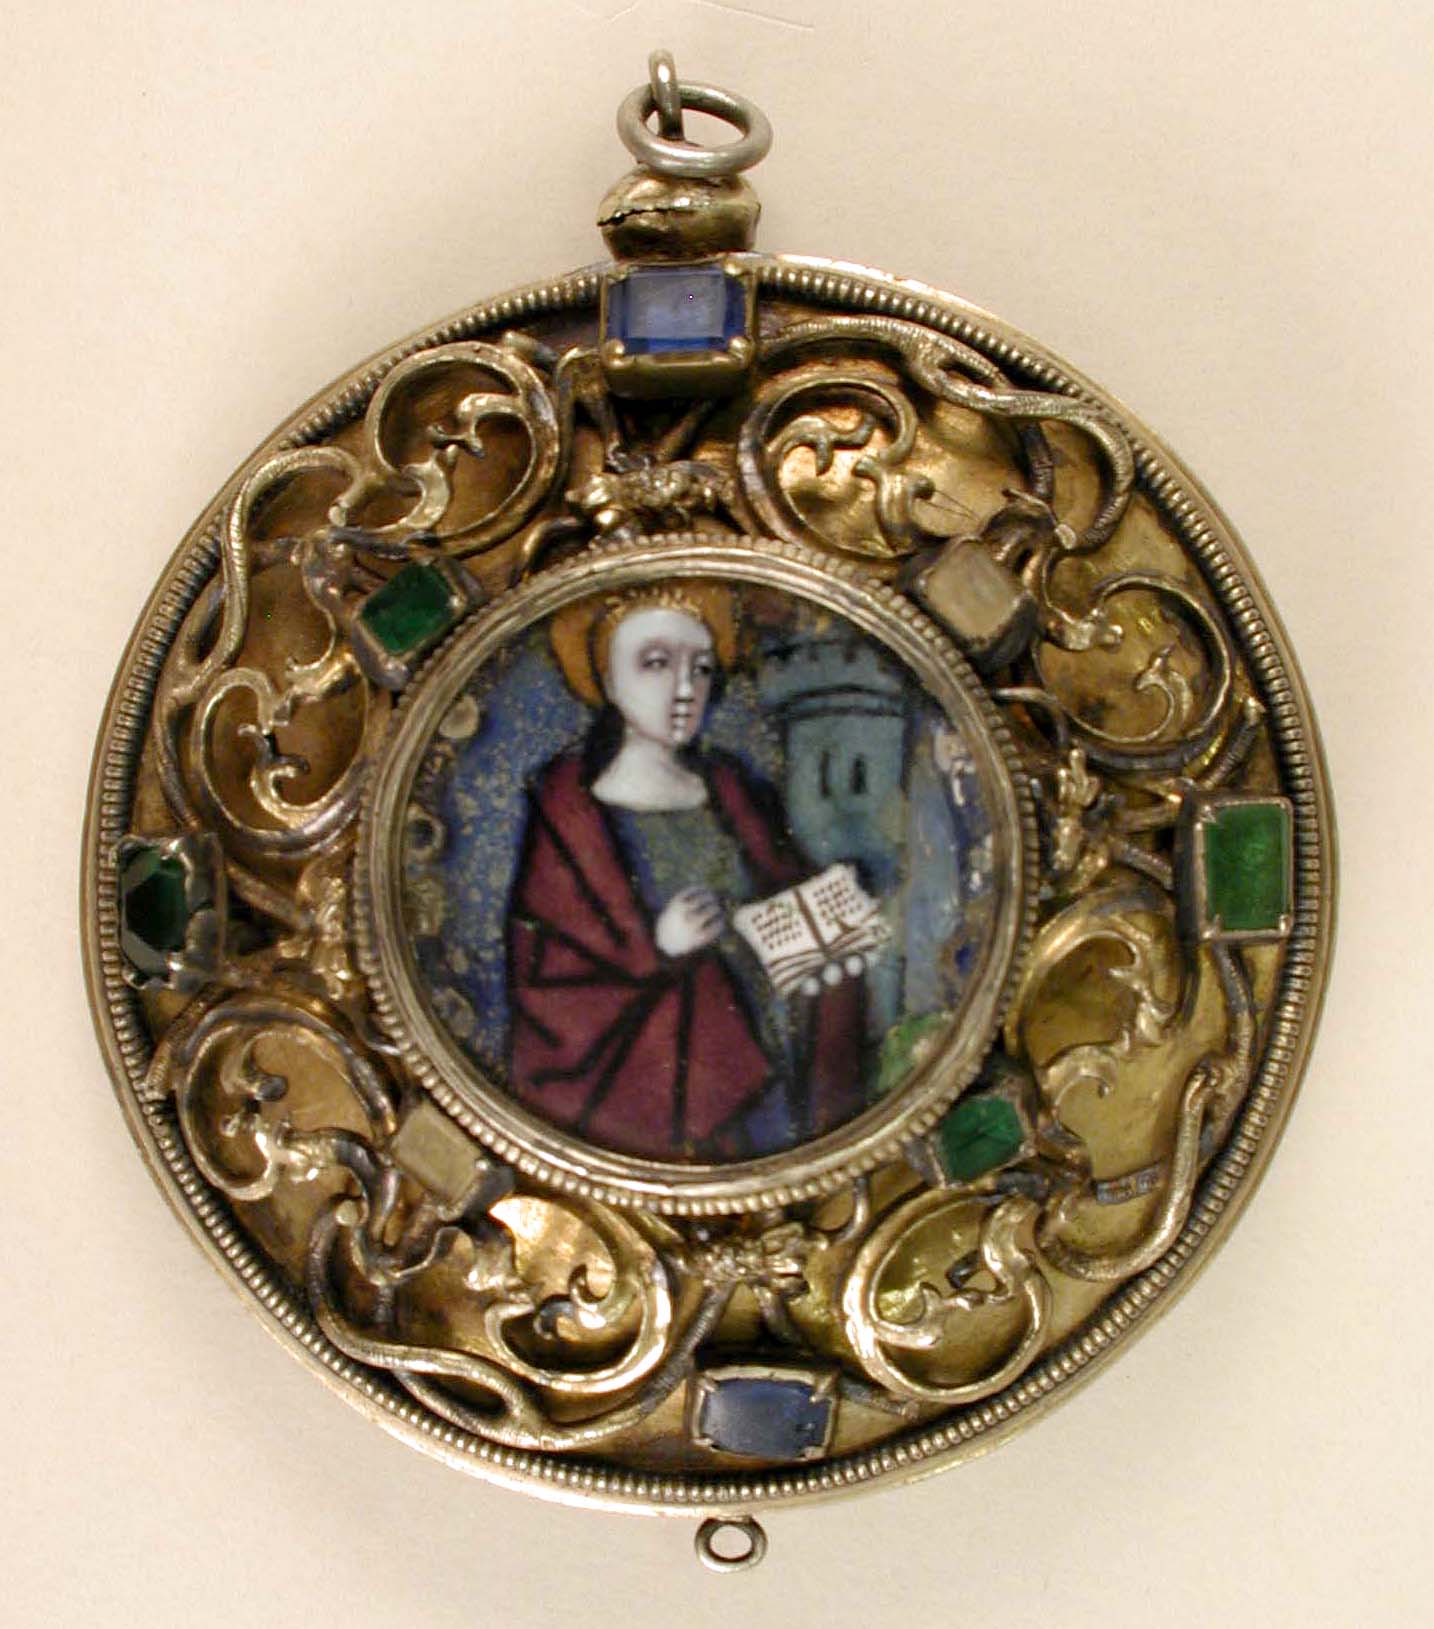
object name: reliquary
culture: french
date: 1801-1900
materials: enamel, glass, silver gilt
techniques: painting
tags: men,portraits,women